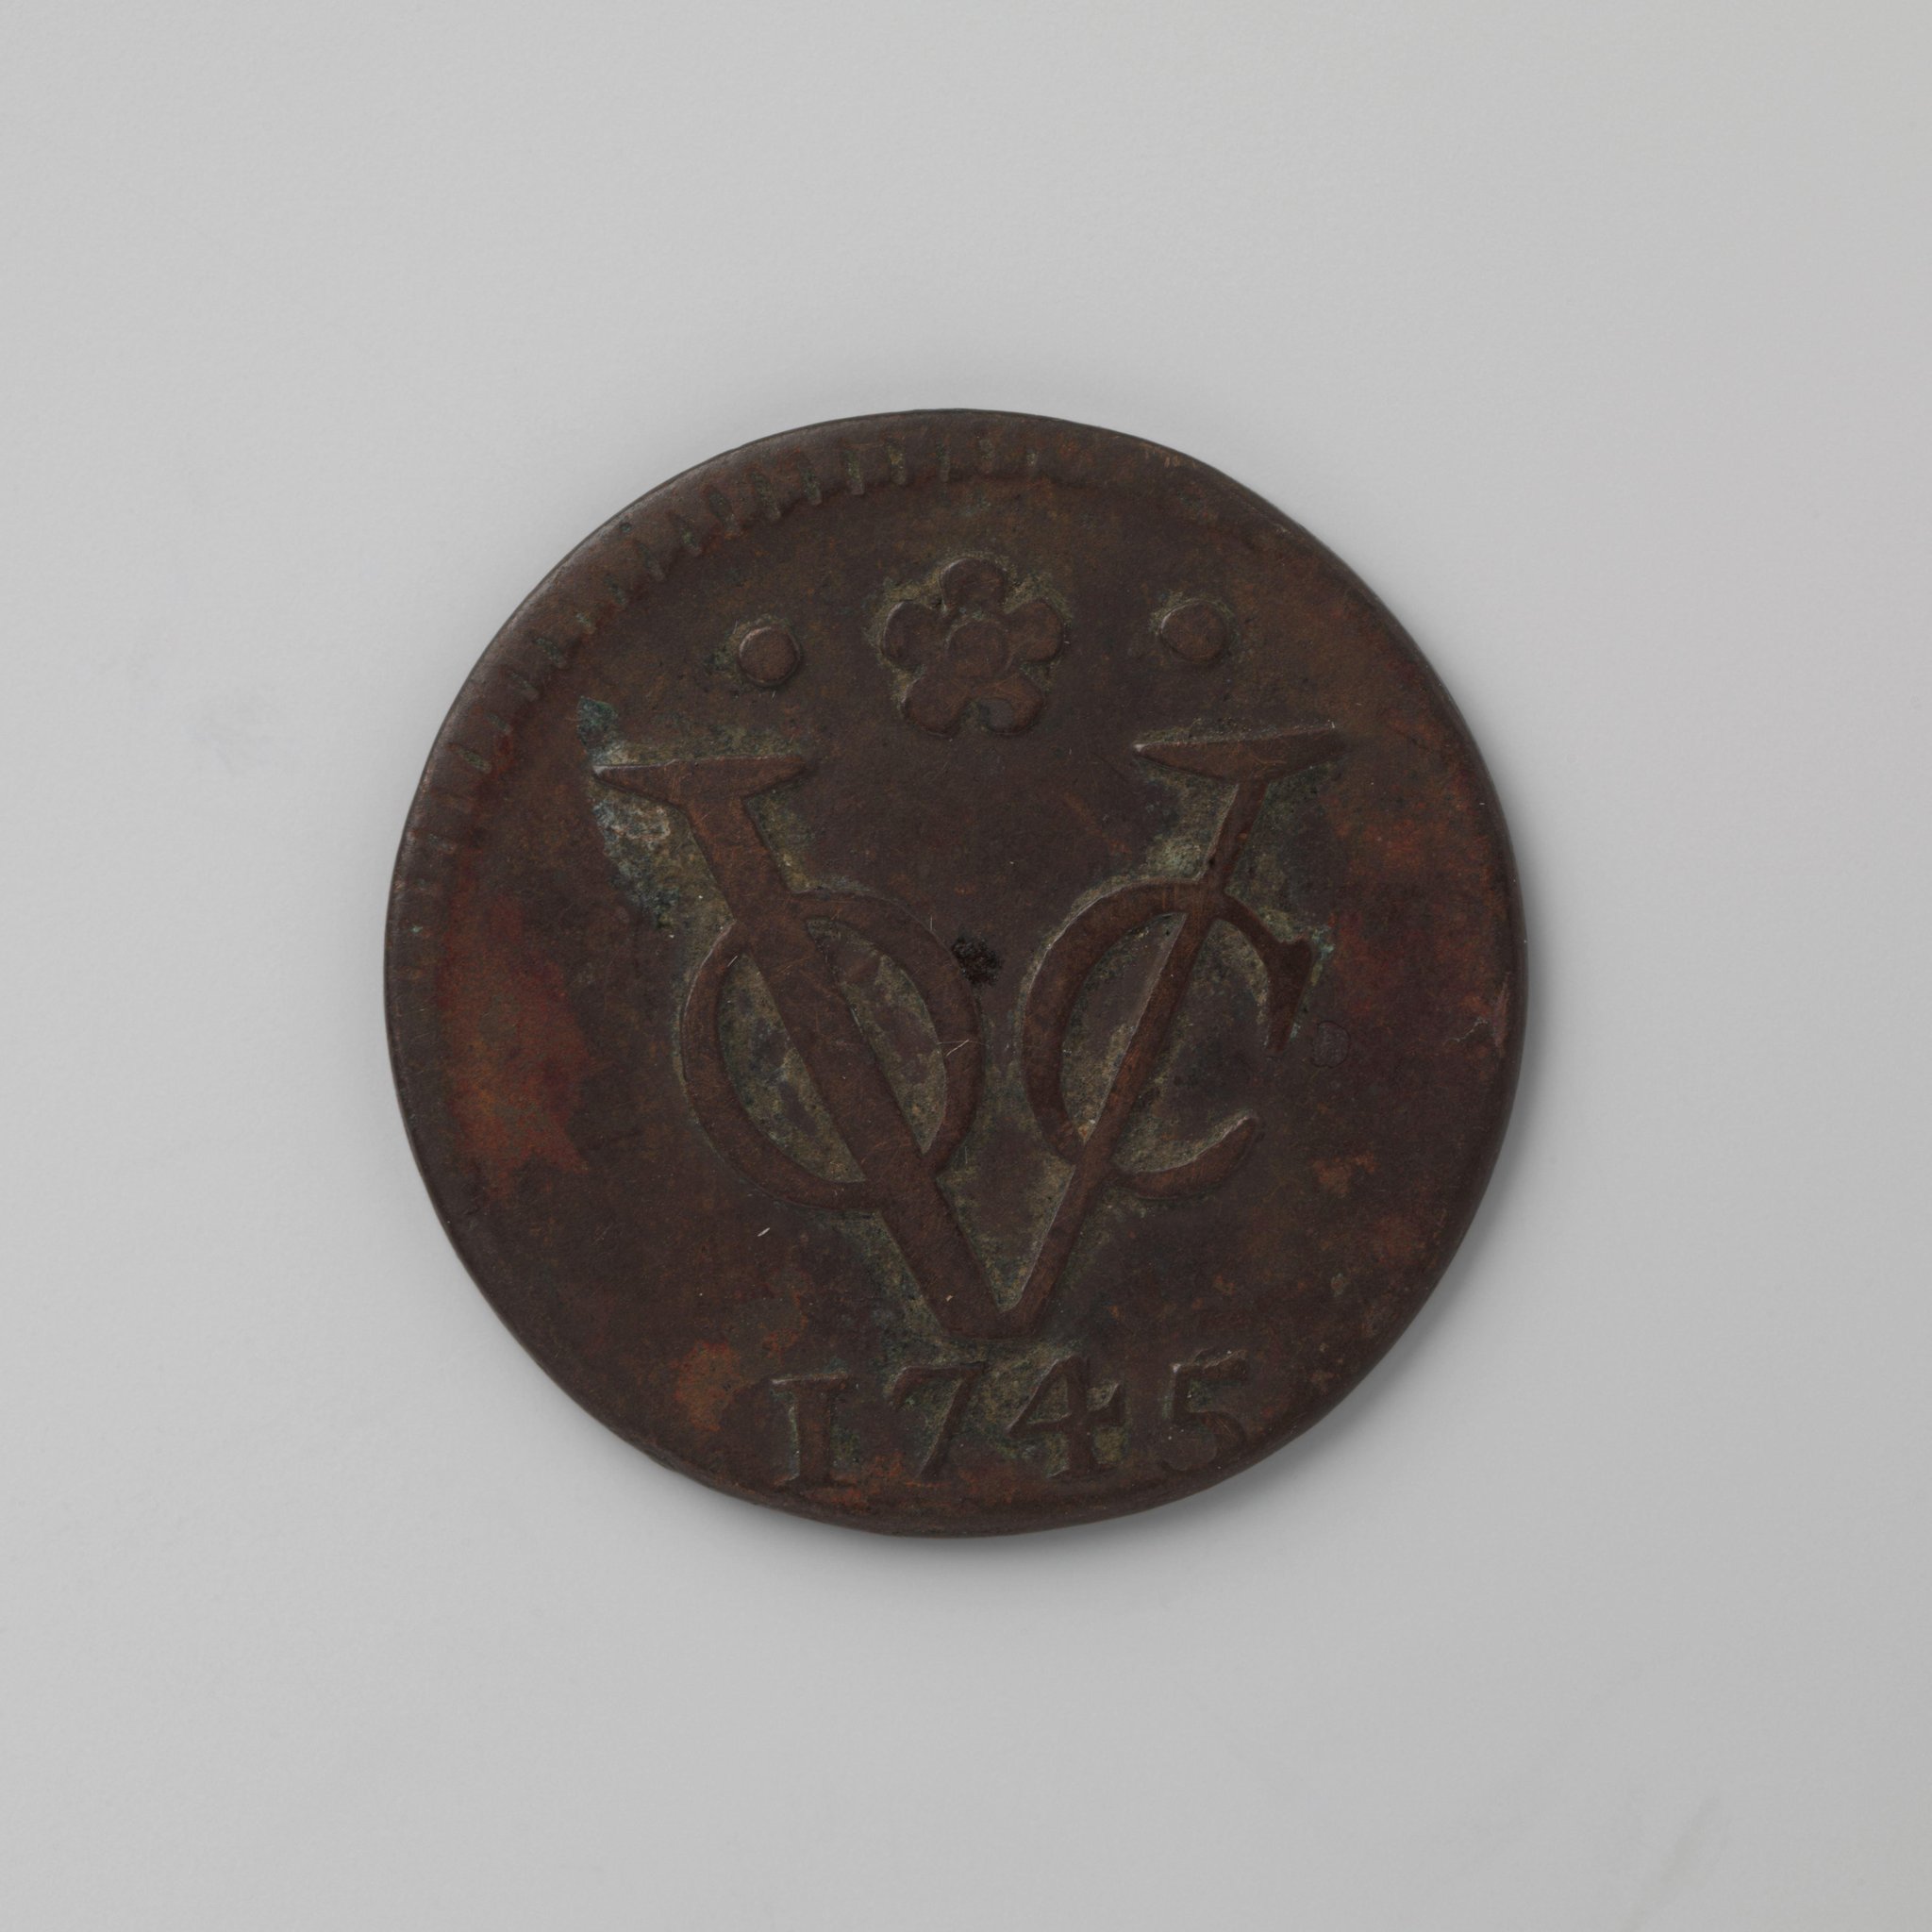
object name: coin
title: VOC, duit Holland, 1745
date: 1745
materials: copper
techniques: striking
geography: dordrecht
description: Koperen munt. Voorzijde: gekroond wapenschild van Holland. Keerzijde: monogram van de VOC, waarboven muntteken en waaronder jaartal. Gladde rand.